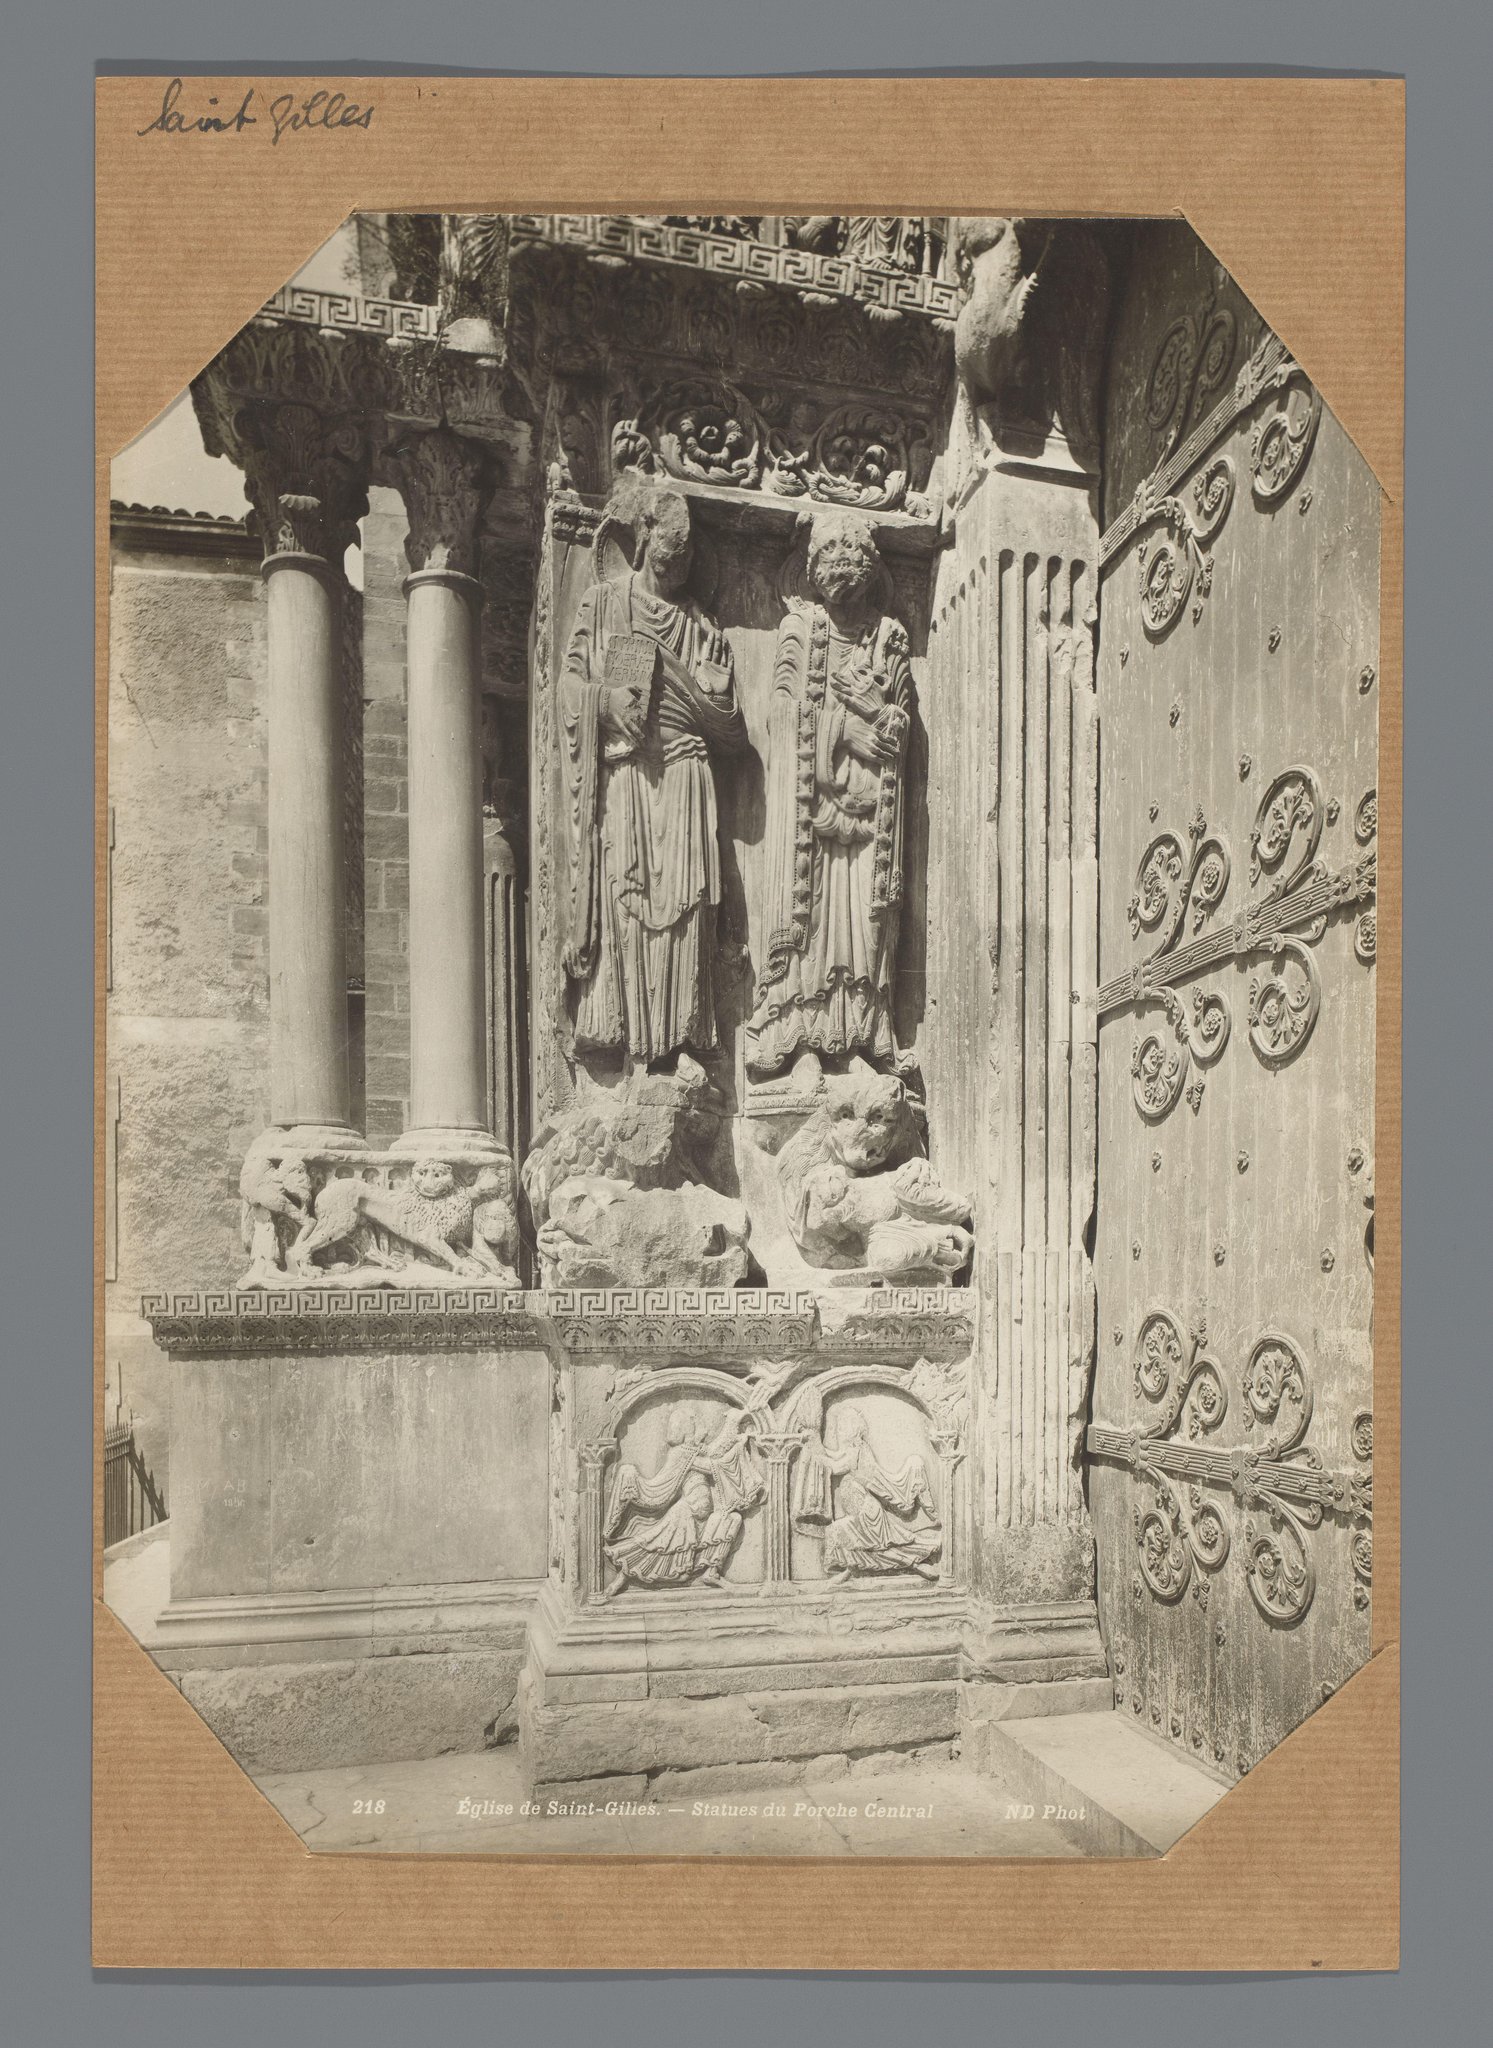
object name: photograph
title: Saint-Gilles, Kirche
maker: Anonymous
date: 1880-1930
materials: photographic support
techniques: gelatin silver print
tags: france